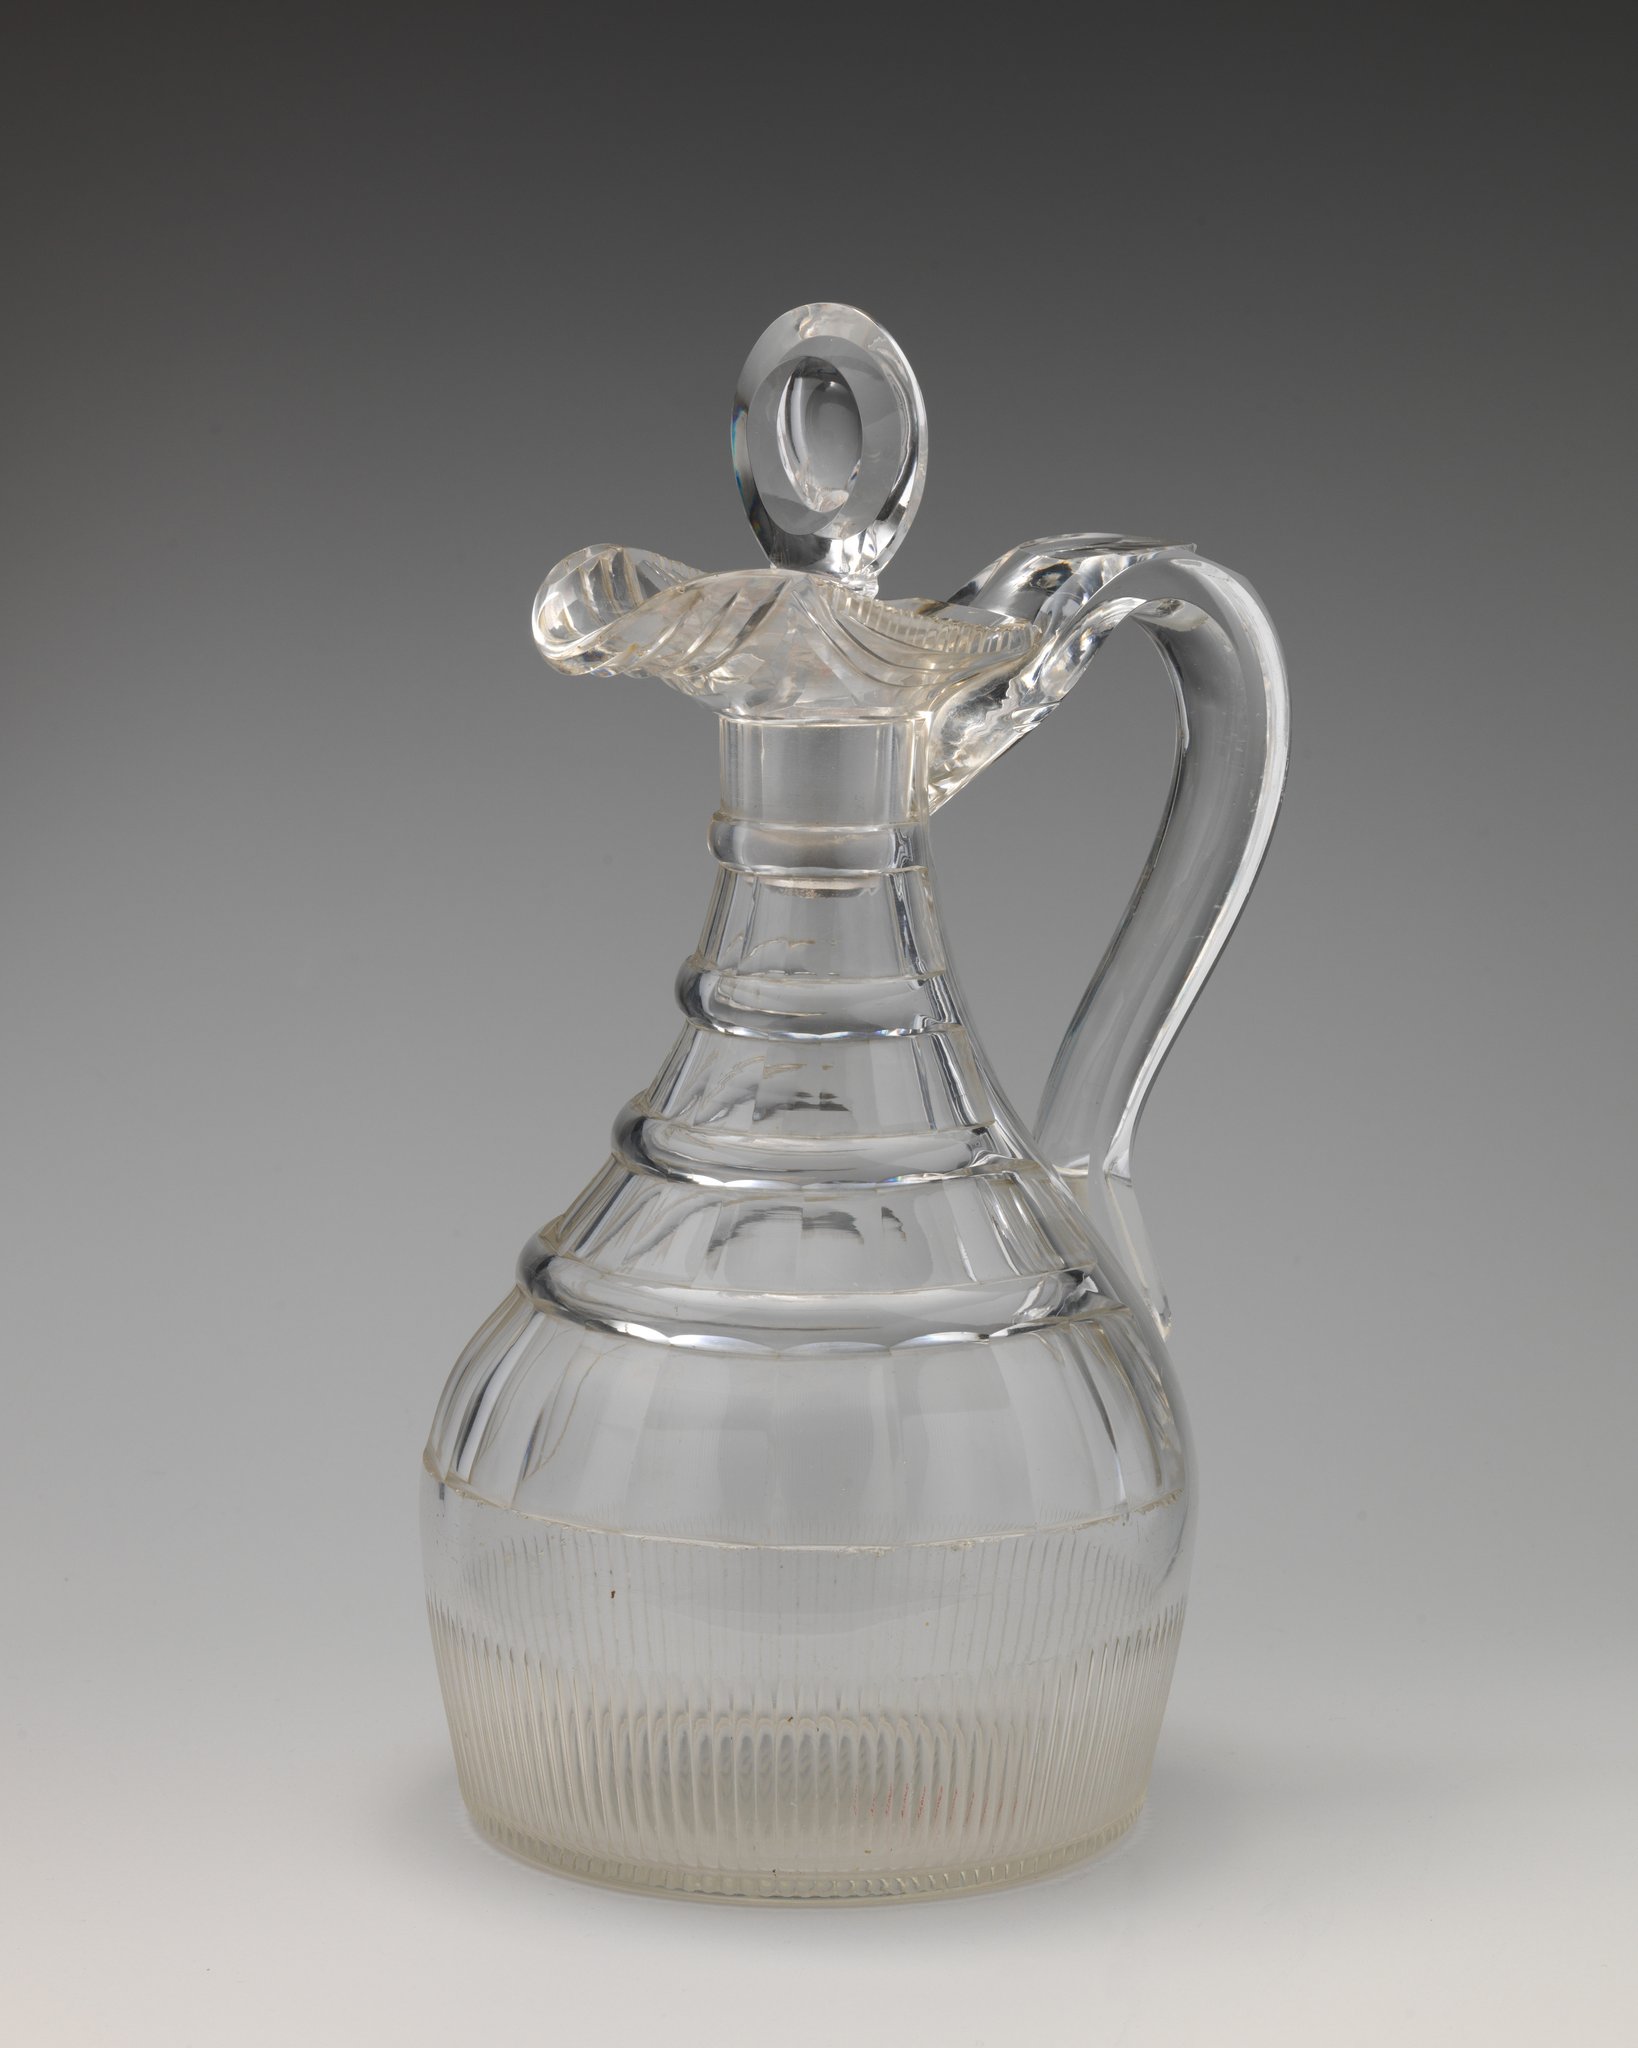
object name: claret jug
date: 1820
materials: glass